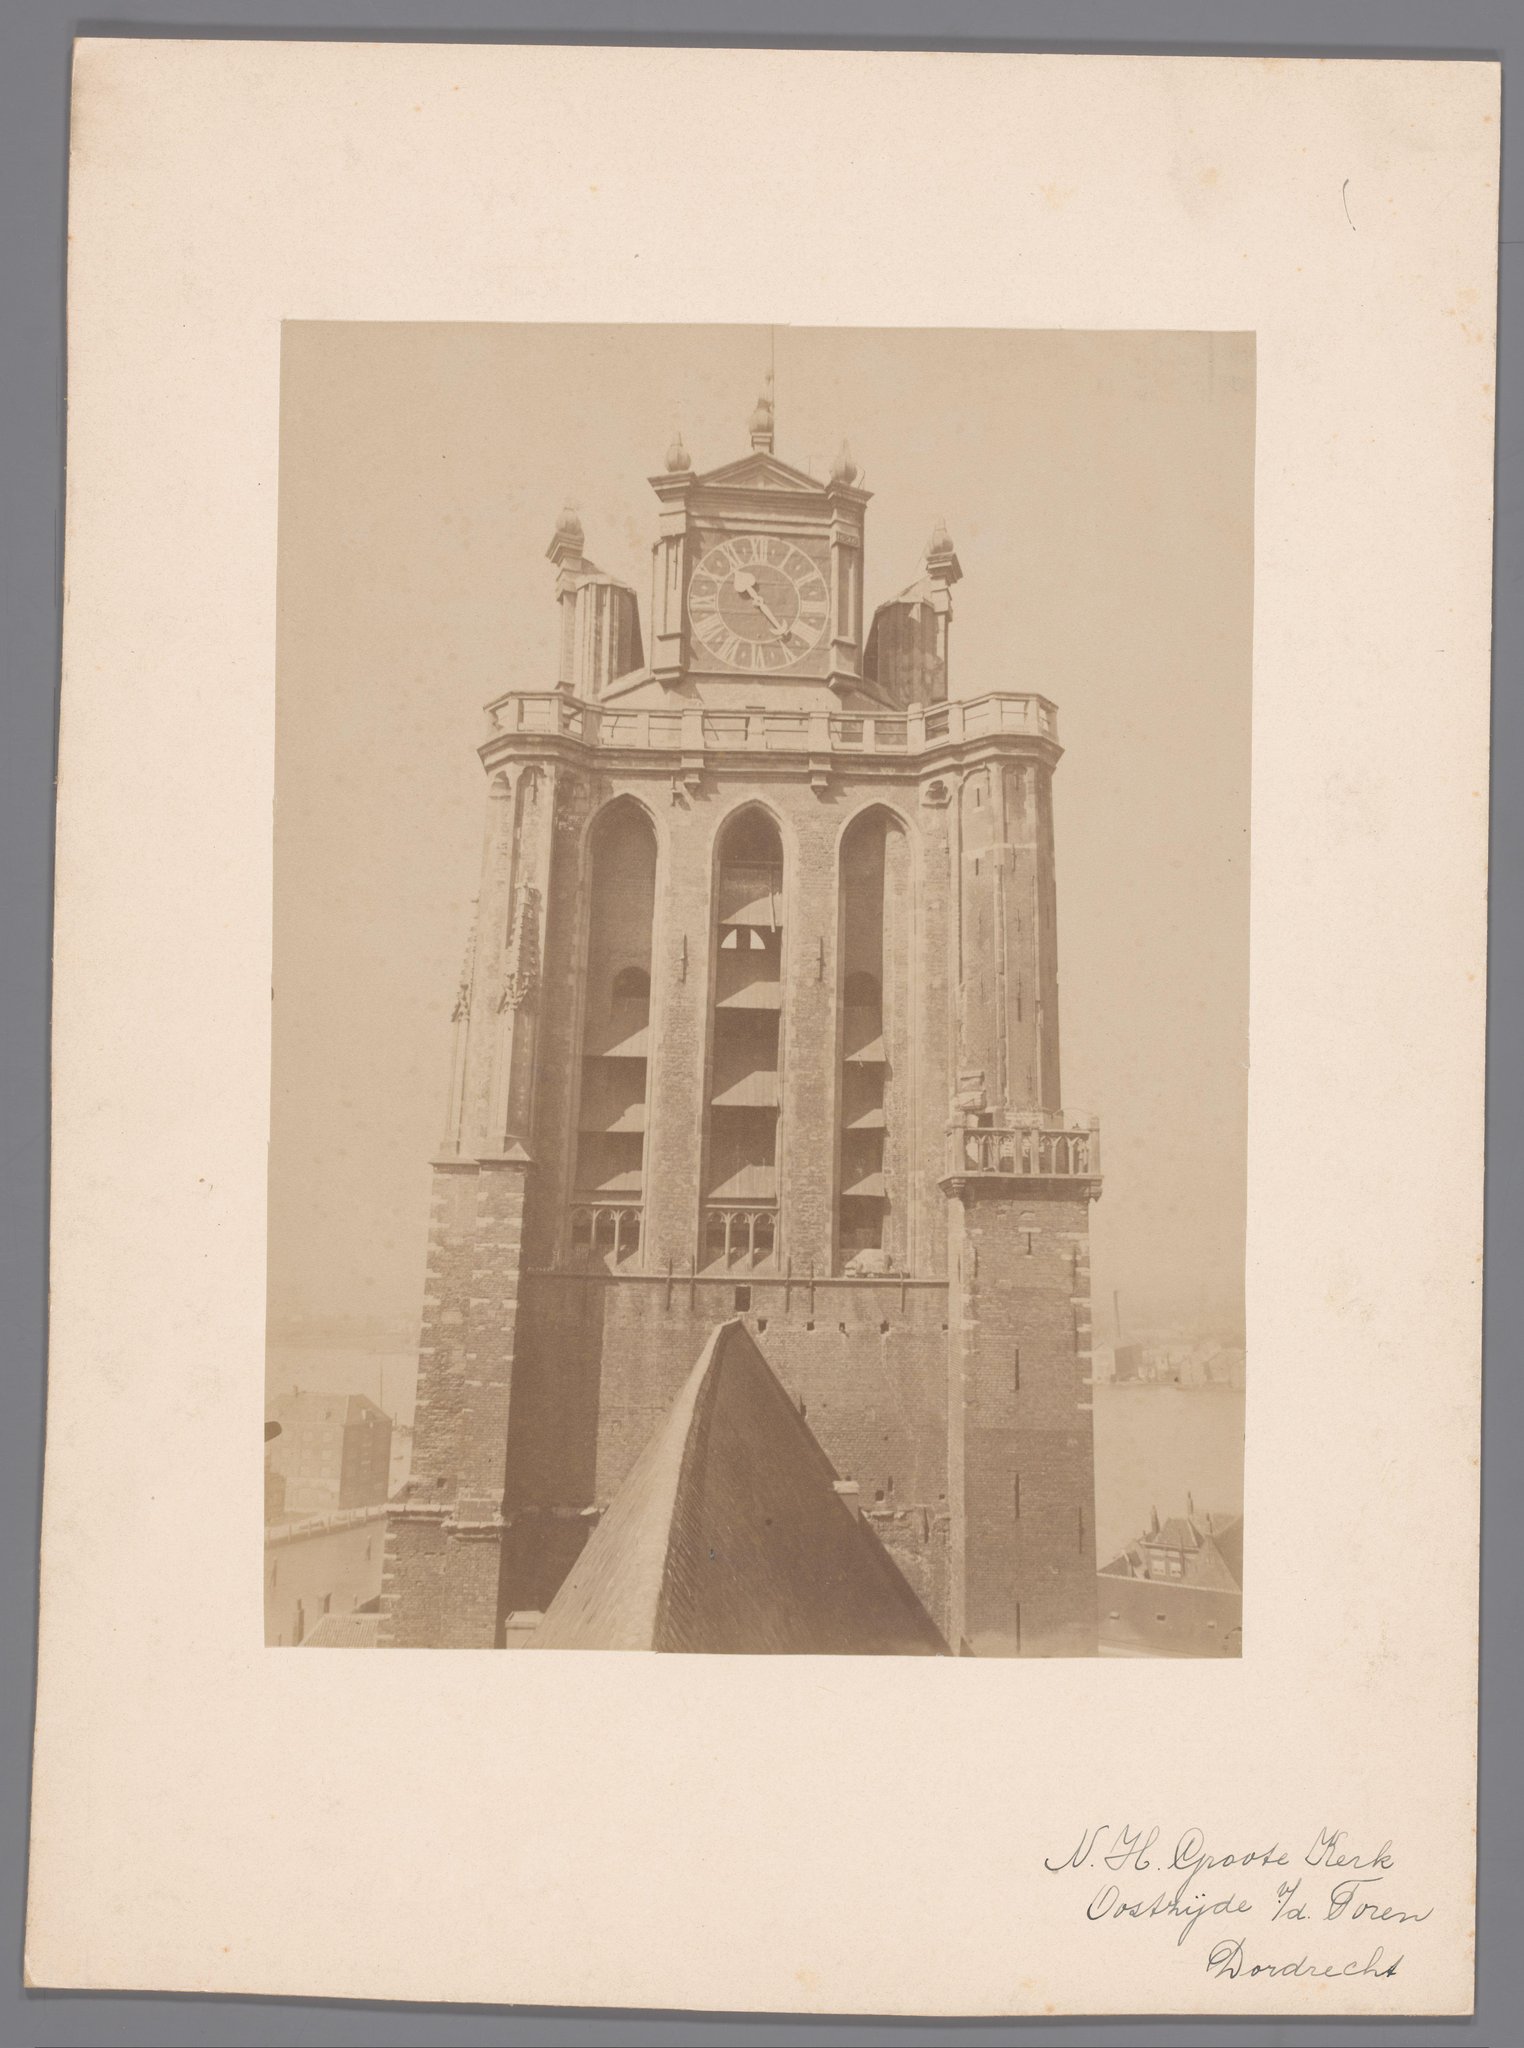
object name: photograph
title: Toren van de Grote of Onze-Lieve-Vrouwenkerk te Dordrecht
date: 1880-1910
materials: cardboard, photographic support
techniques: albumen print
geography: grote of onze-lieve-vrouwekerk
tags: church (exterior), parts of church exterior and annexes: tower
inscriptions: annotation: ‘N.H. Groote Kerk/ Oostzijde v/d Toren/ Dordrecht’, annotation: ‘Dordrecht/ Oostzijde v/d Toren’